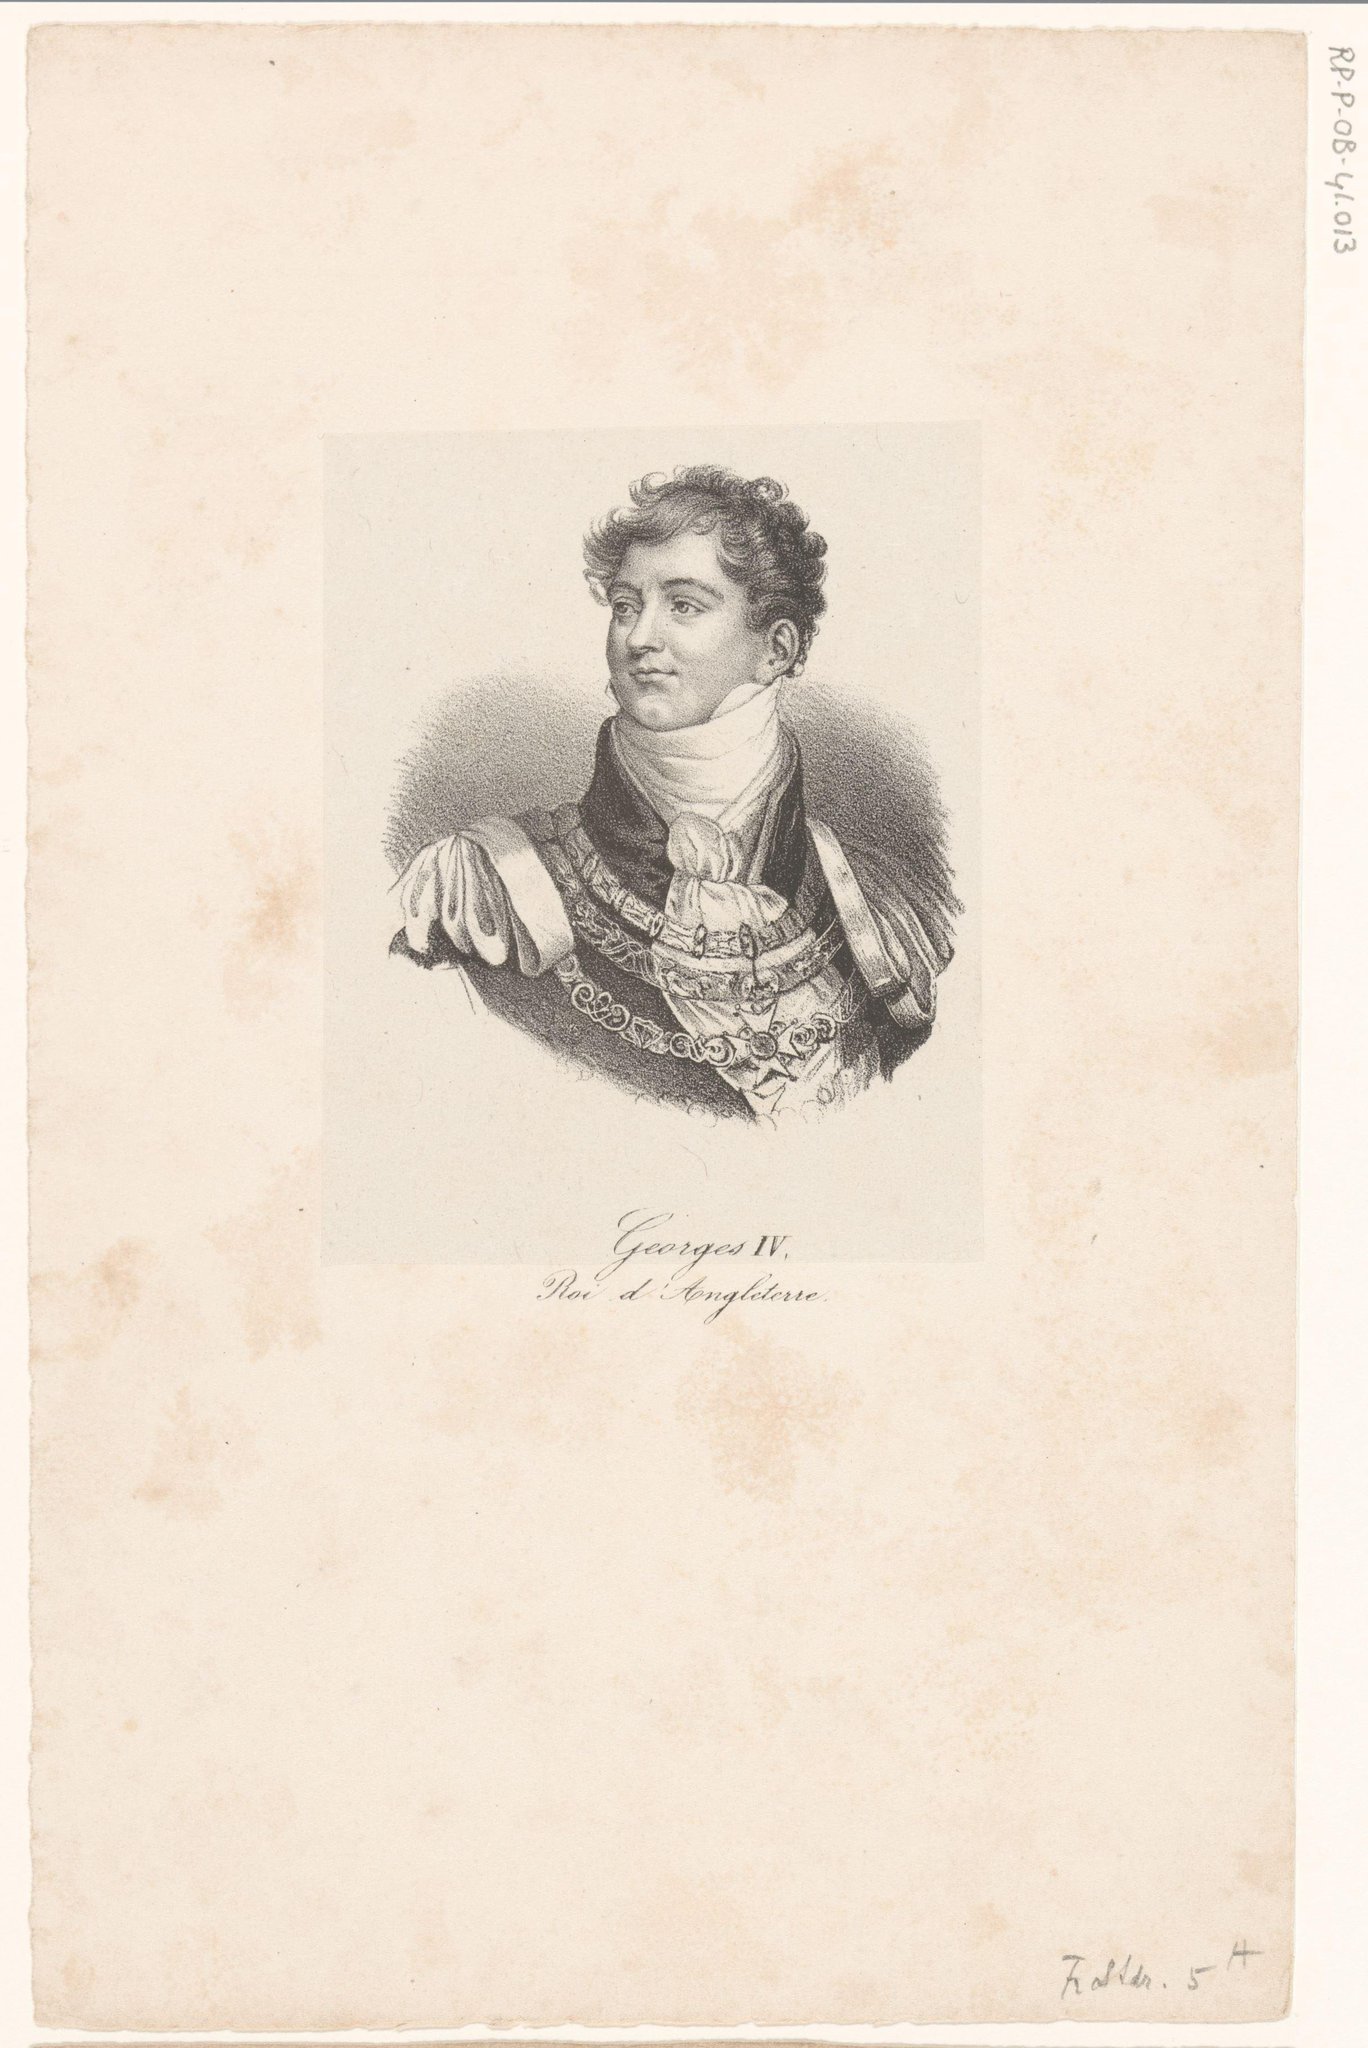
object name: print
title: Portret van George IV van het Verenigd Koninkrijk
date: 1818-1842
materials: paper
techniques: lithograph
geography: paris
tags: george iv (koning van het verenigd koninkrijk), historical persons